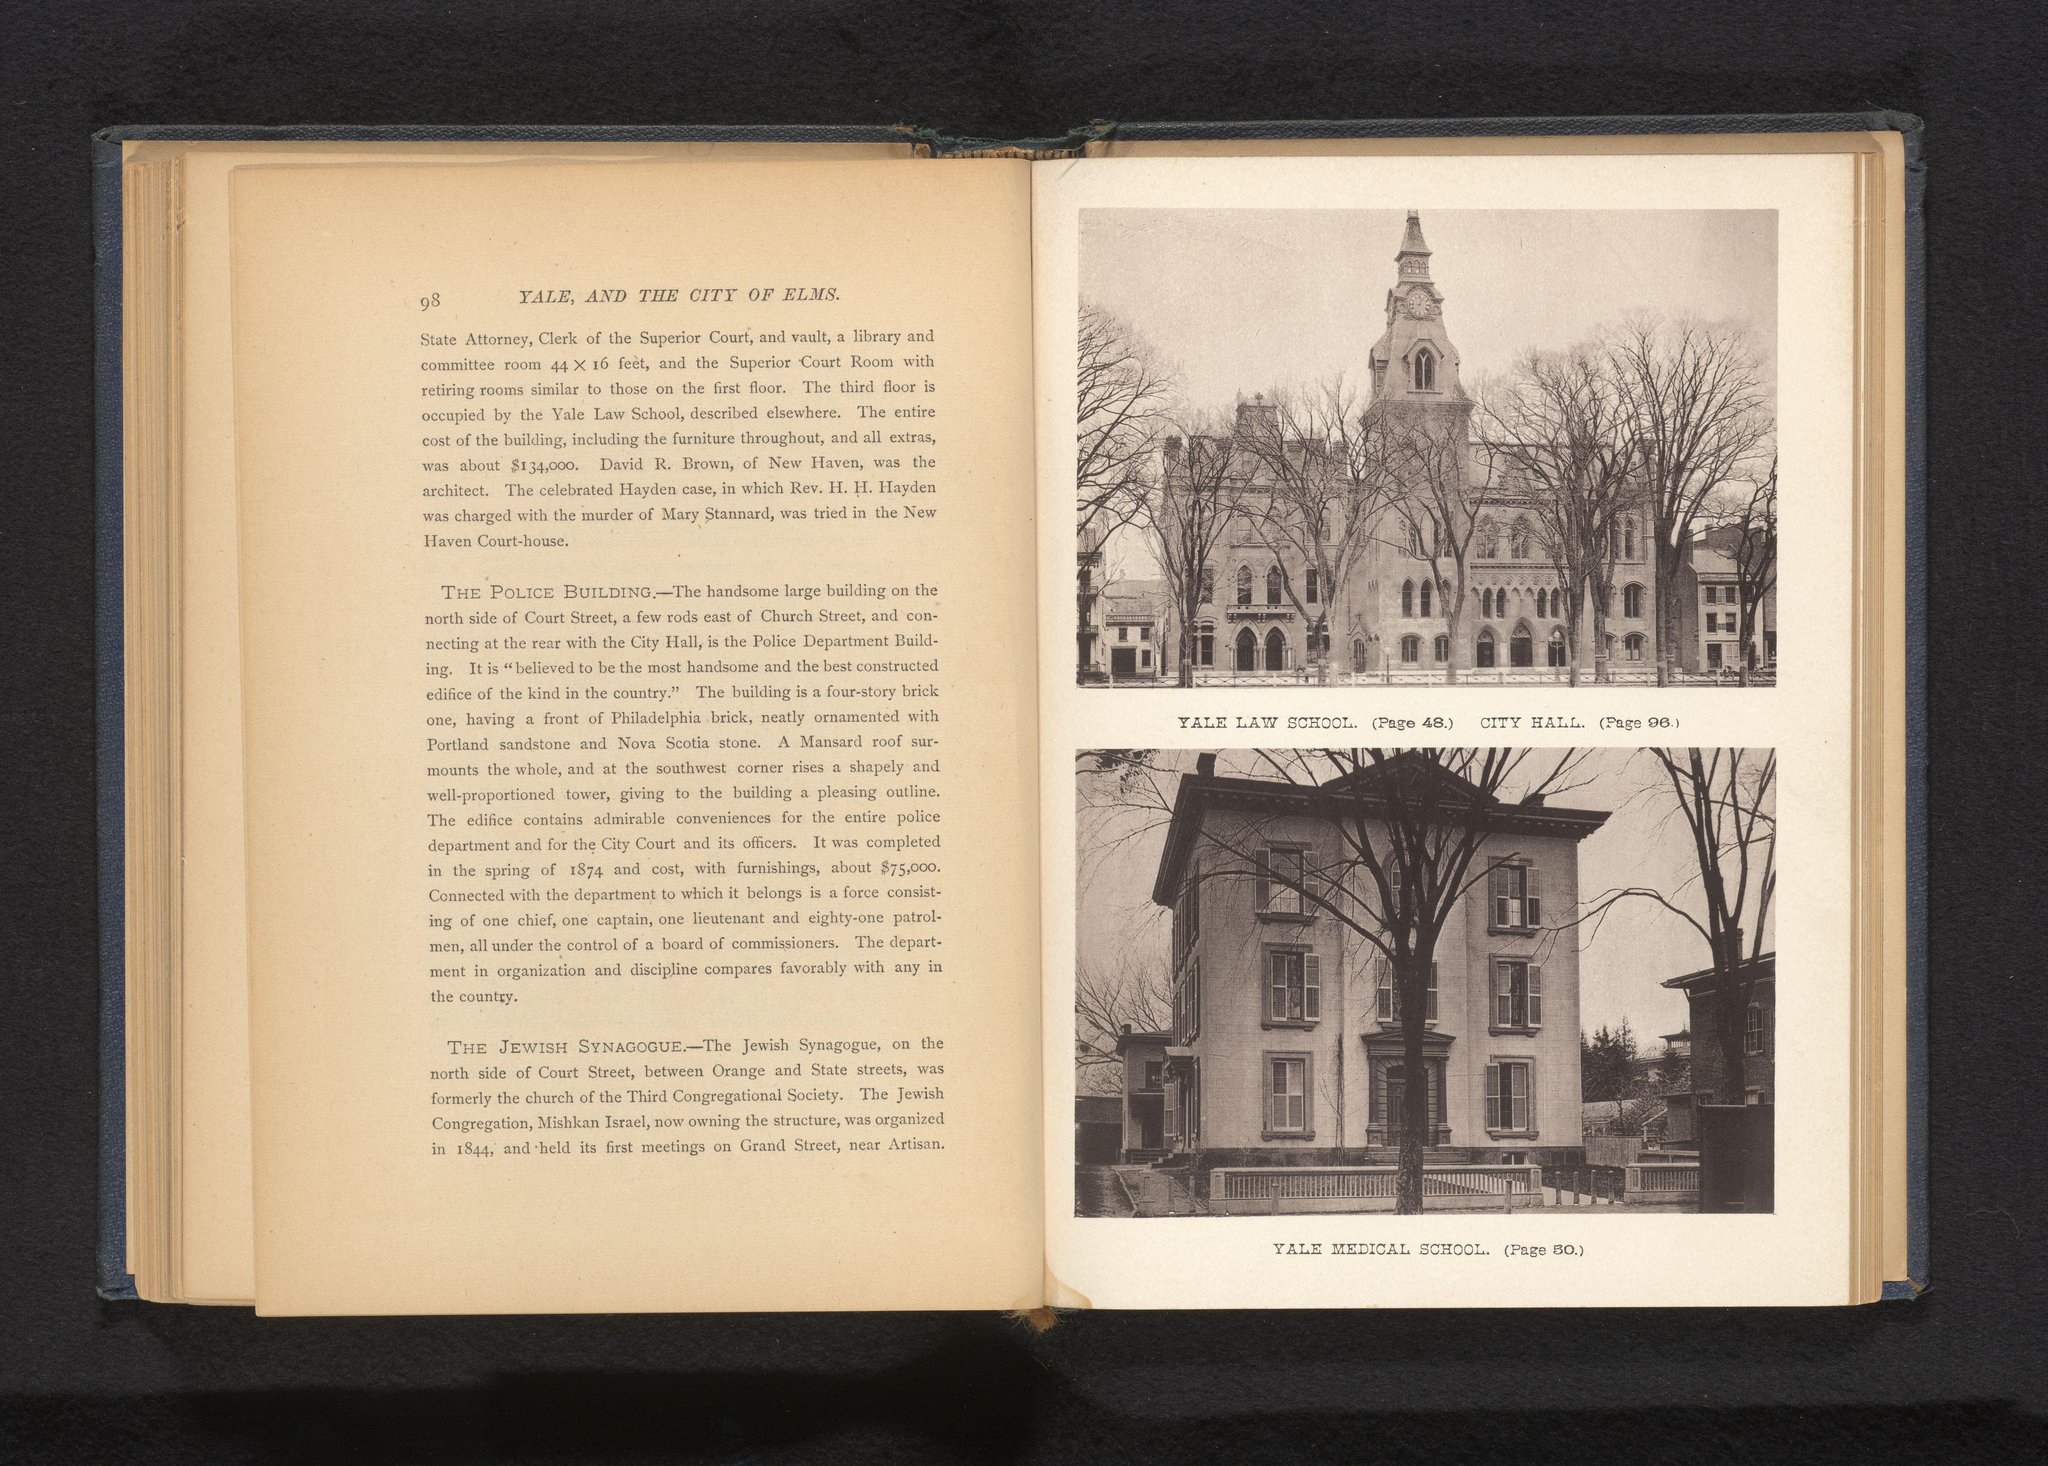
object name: page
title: Yale Law School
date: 1872-1882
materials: paper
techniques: photograph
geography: new haven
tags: university, façade (of house or building)